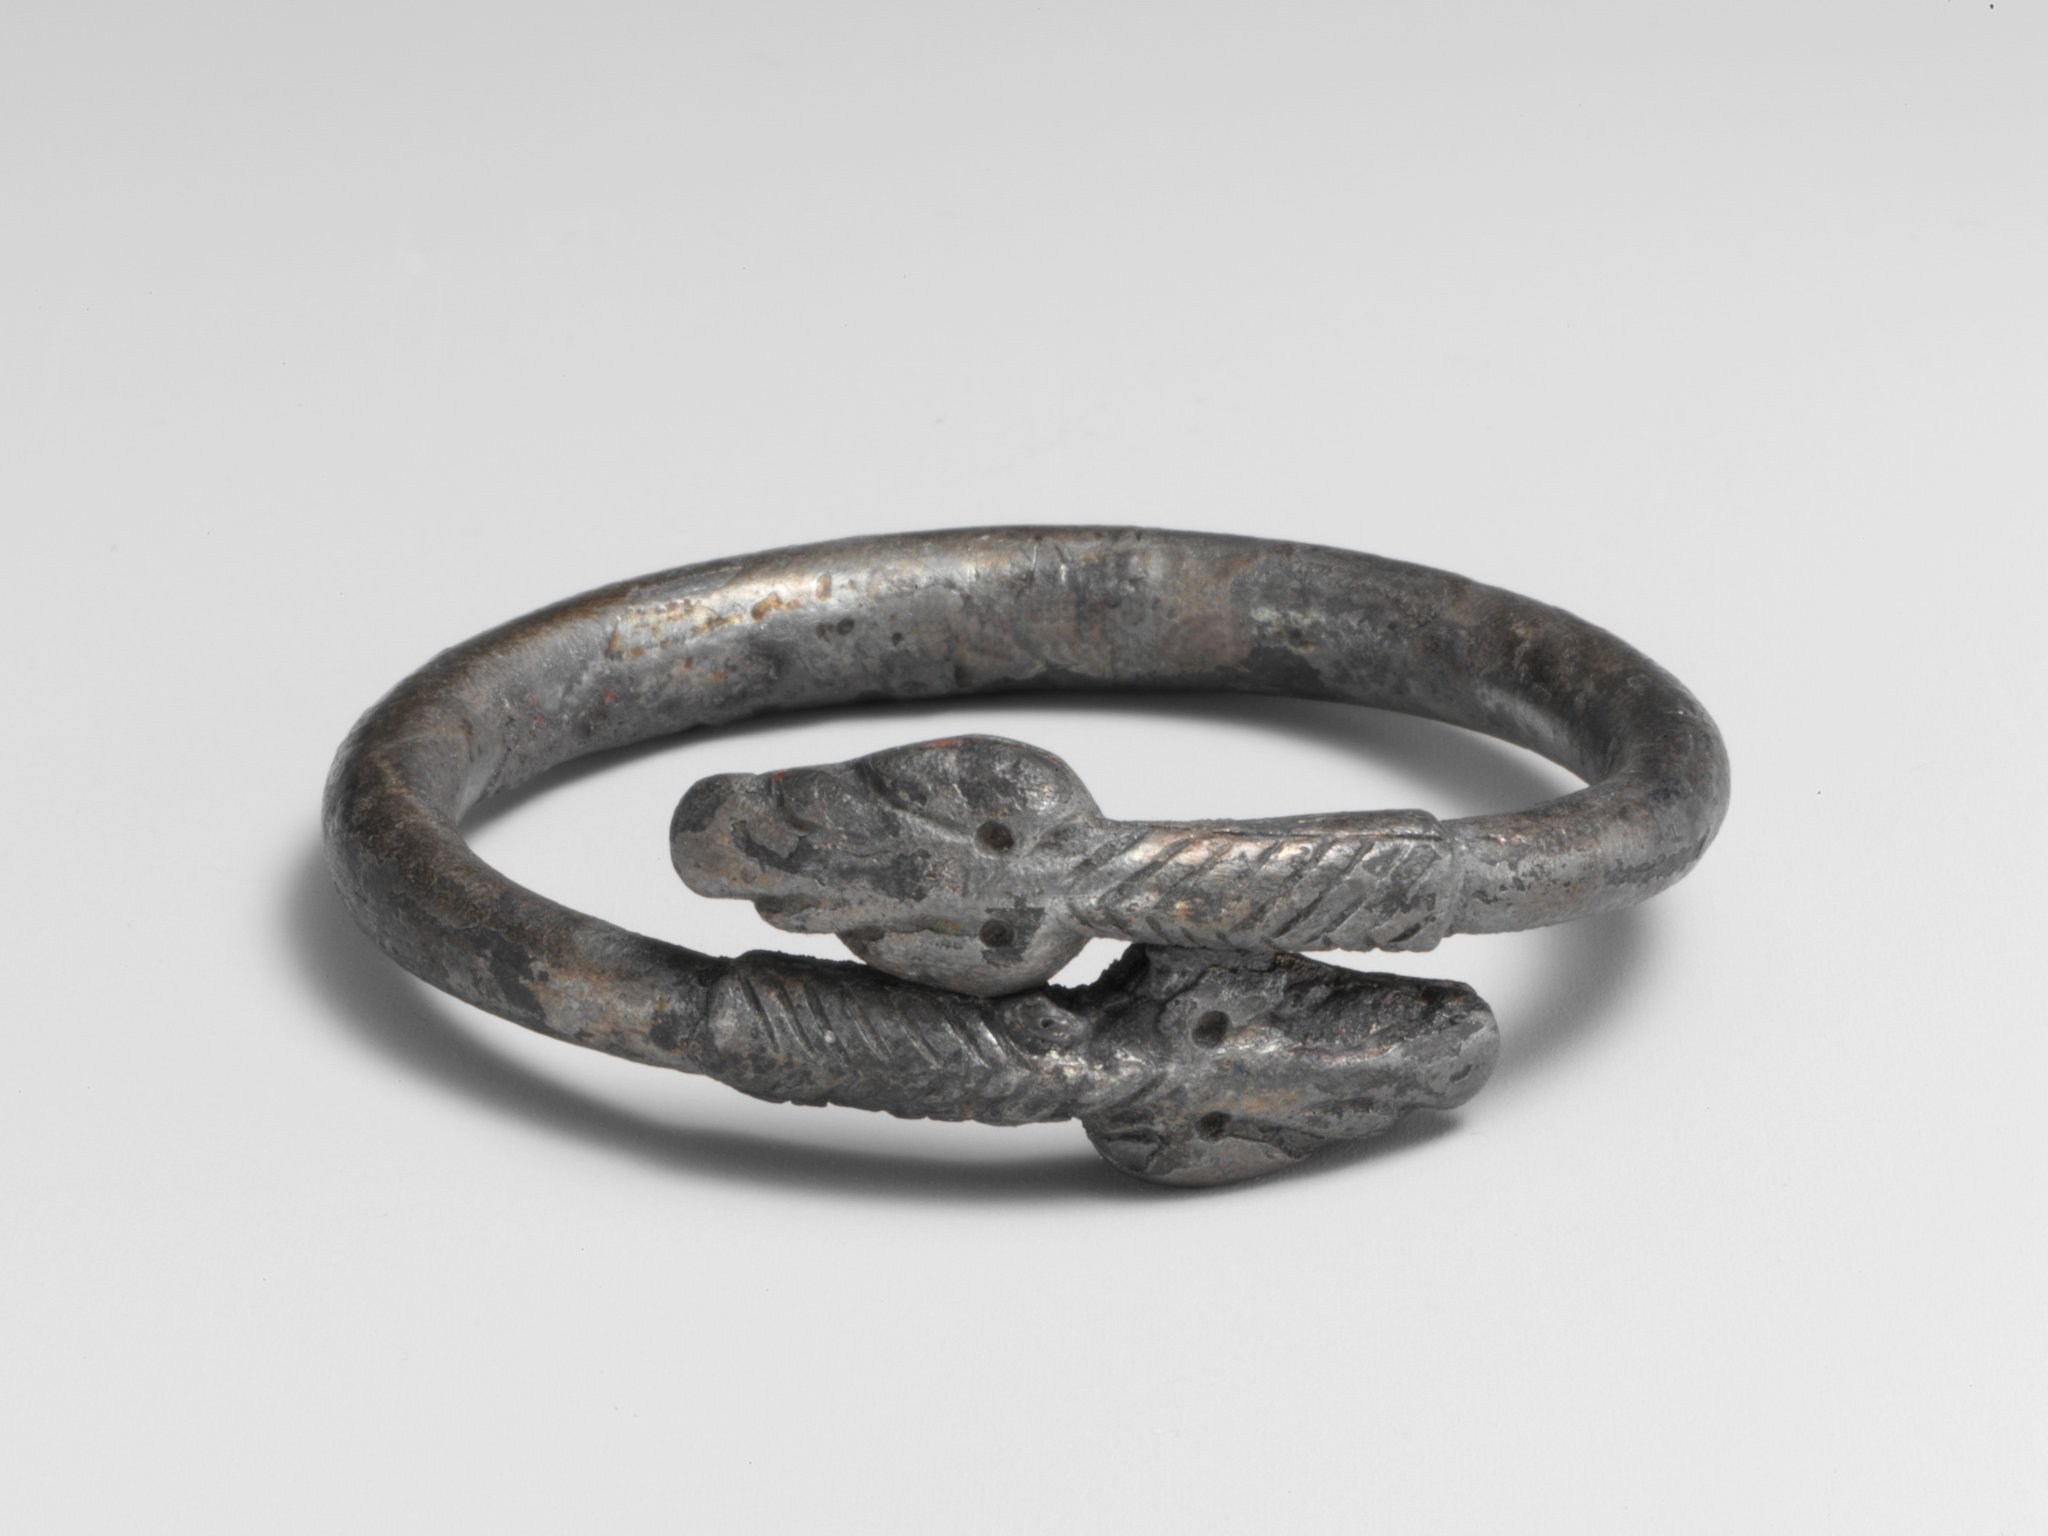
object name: bracelet with snakes' head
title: Silver bracelet in the form of a snake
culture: roman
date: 201-300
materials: silver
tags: snakes